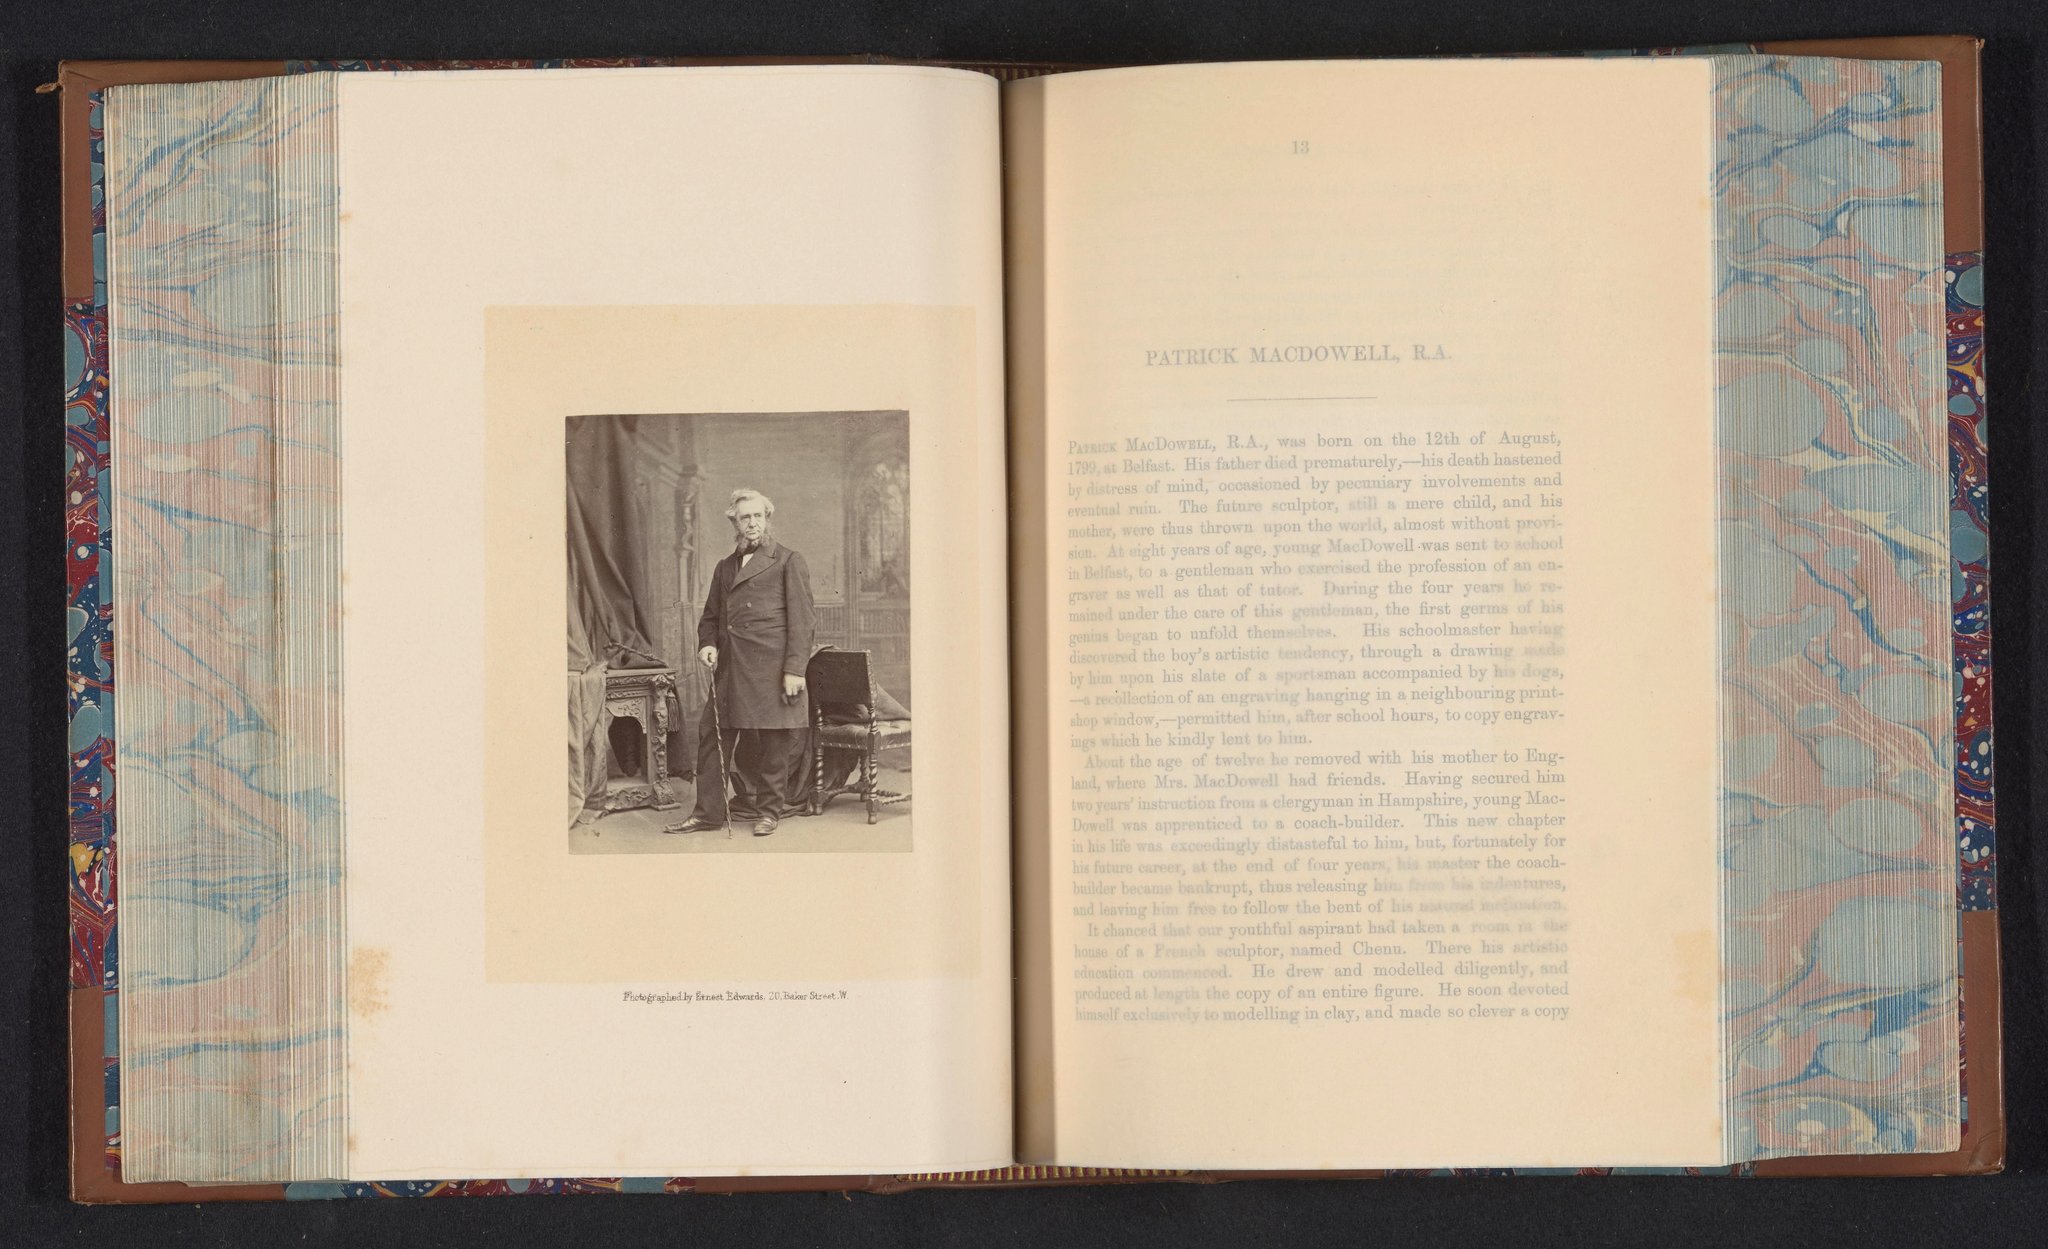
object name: photograph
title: Portret van Patrick MacDowell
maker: ernest edwards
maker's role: fotograaf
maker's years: 1837-1903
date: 1853-1867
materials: photographic support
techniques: albumen print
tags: london, sculptor, patrick macdowell, studio requisites ~ photographer, portrait, self-portrait of sculptor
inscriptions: name: ‘Photographed by Ernest Edwards, 20, Baker Street. W.’